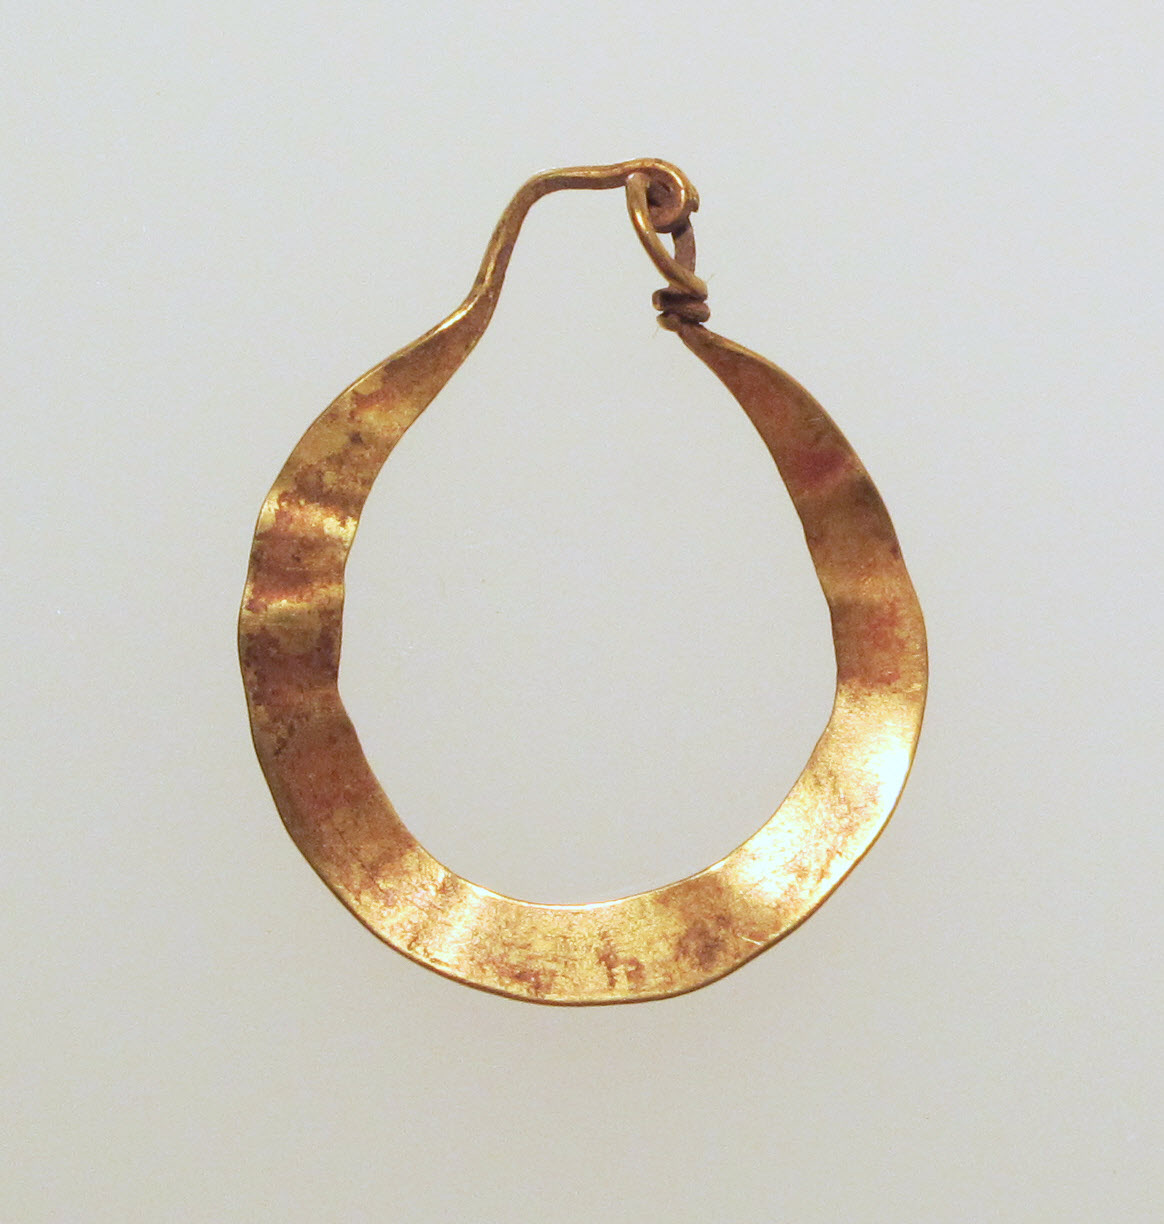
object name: earring, crescent shaped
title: Earring, crescent-shaped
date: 7000 BCE-330 CE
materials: gold